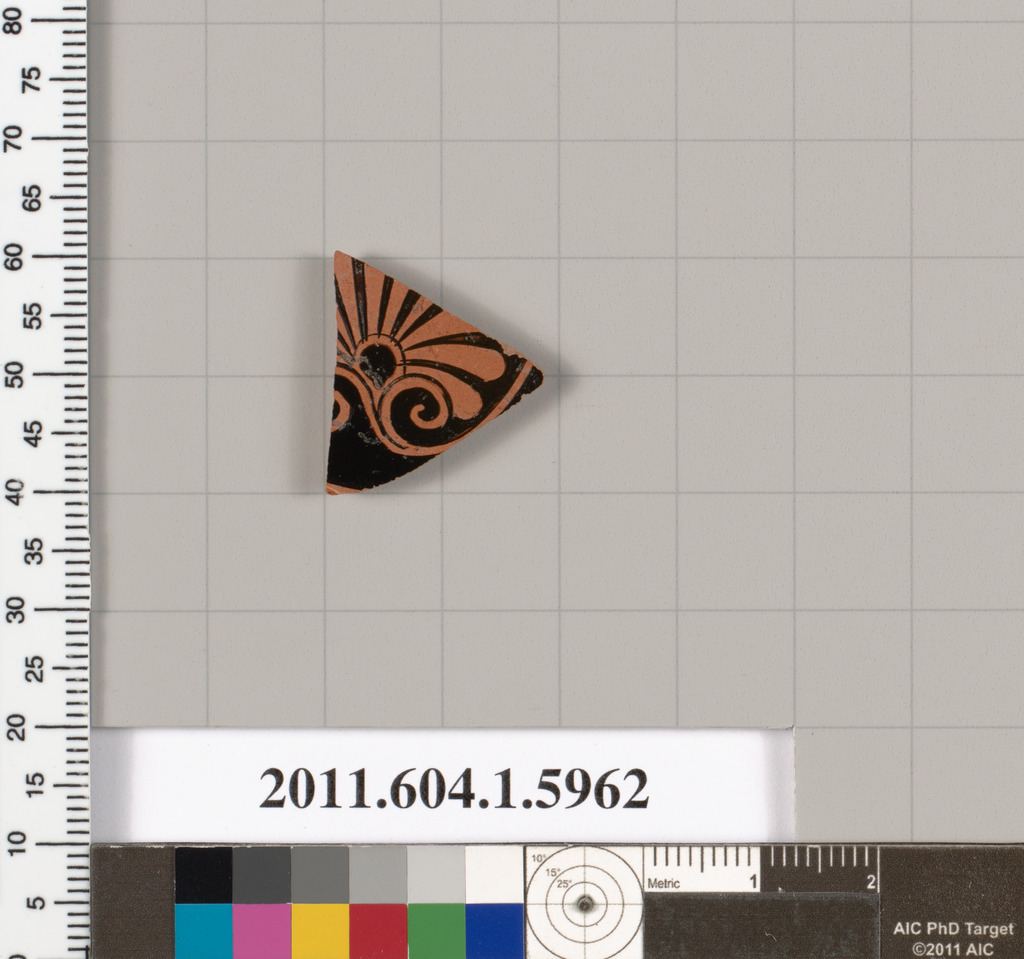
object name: kylix fragment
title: Terracotta fragment of a kylix (drinking cup)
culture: greek, attic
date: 433-567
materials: terracotta